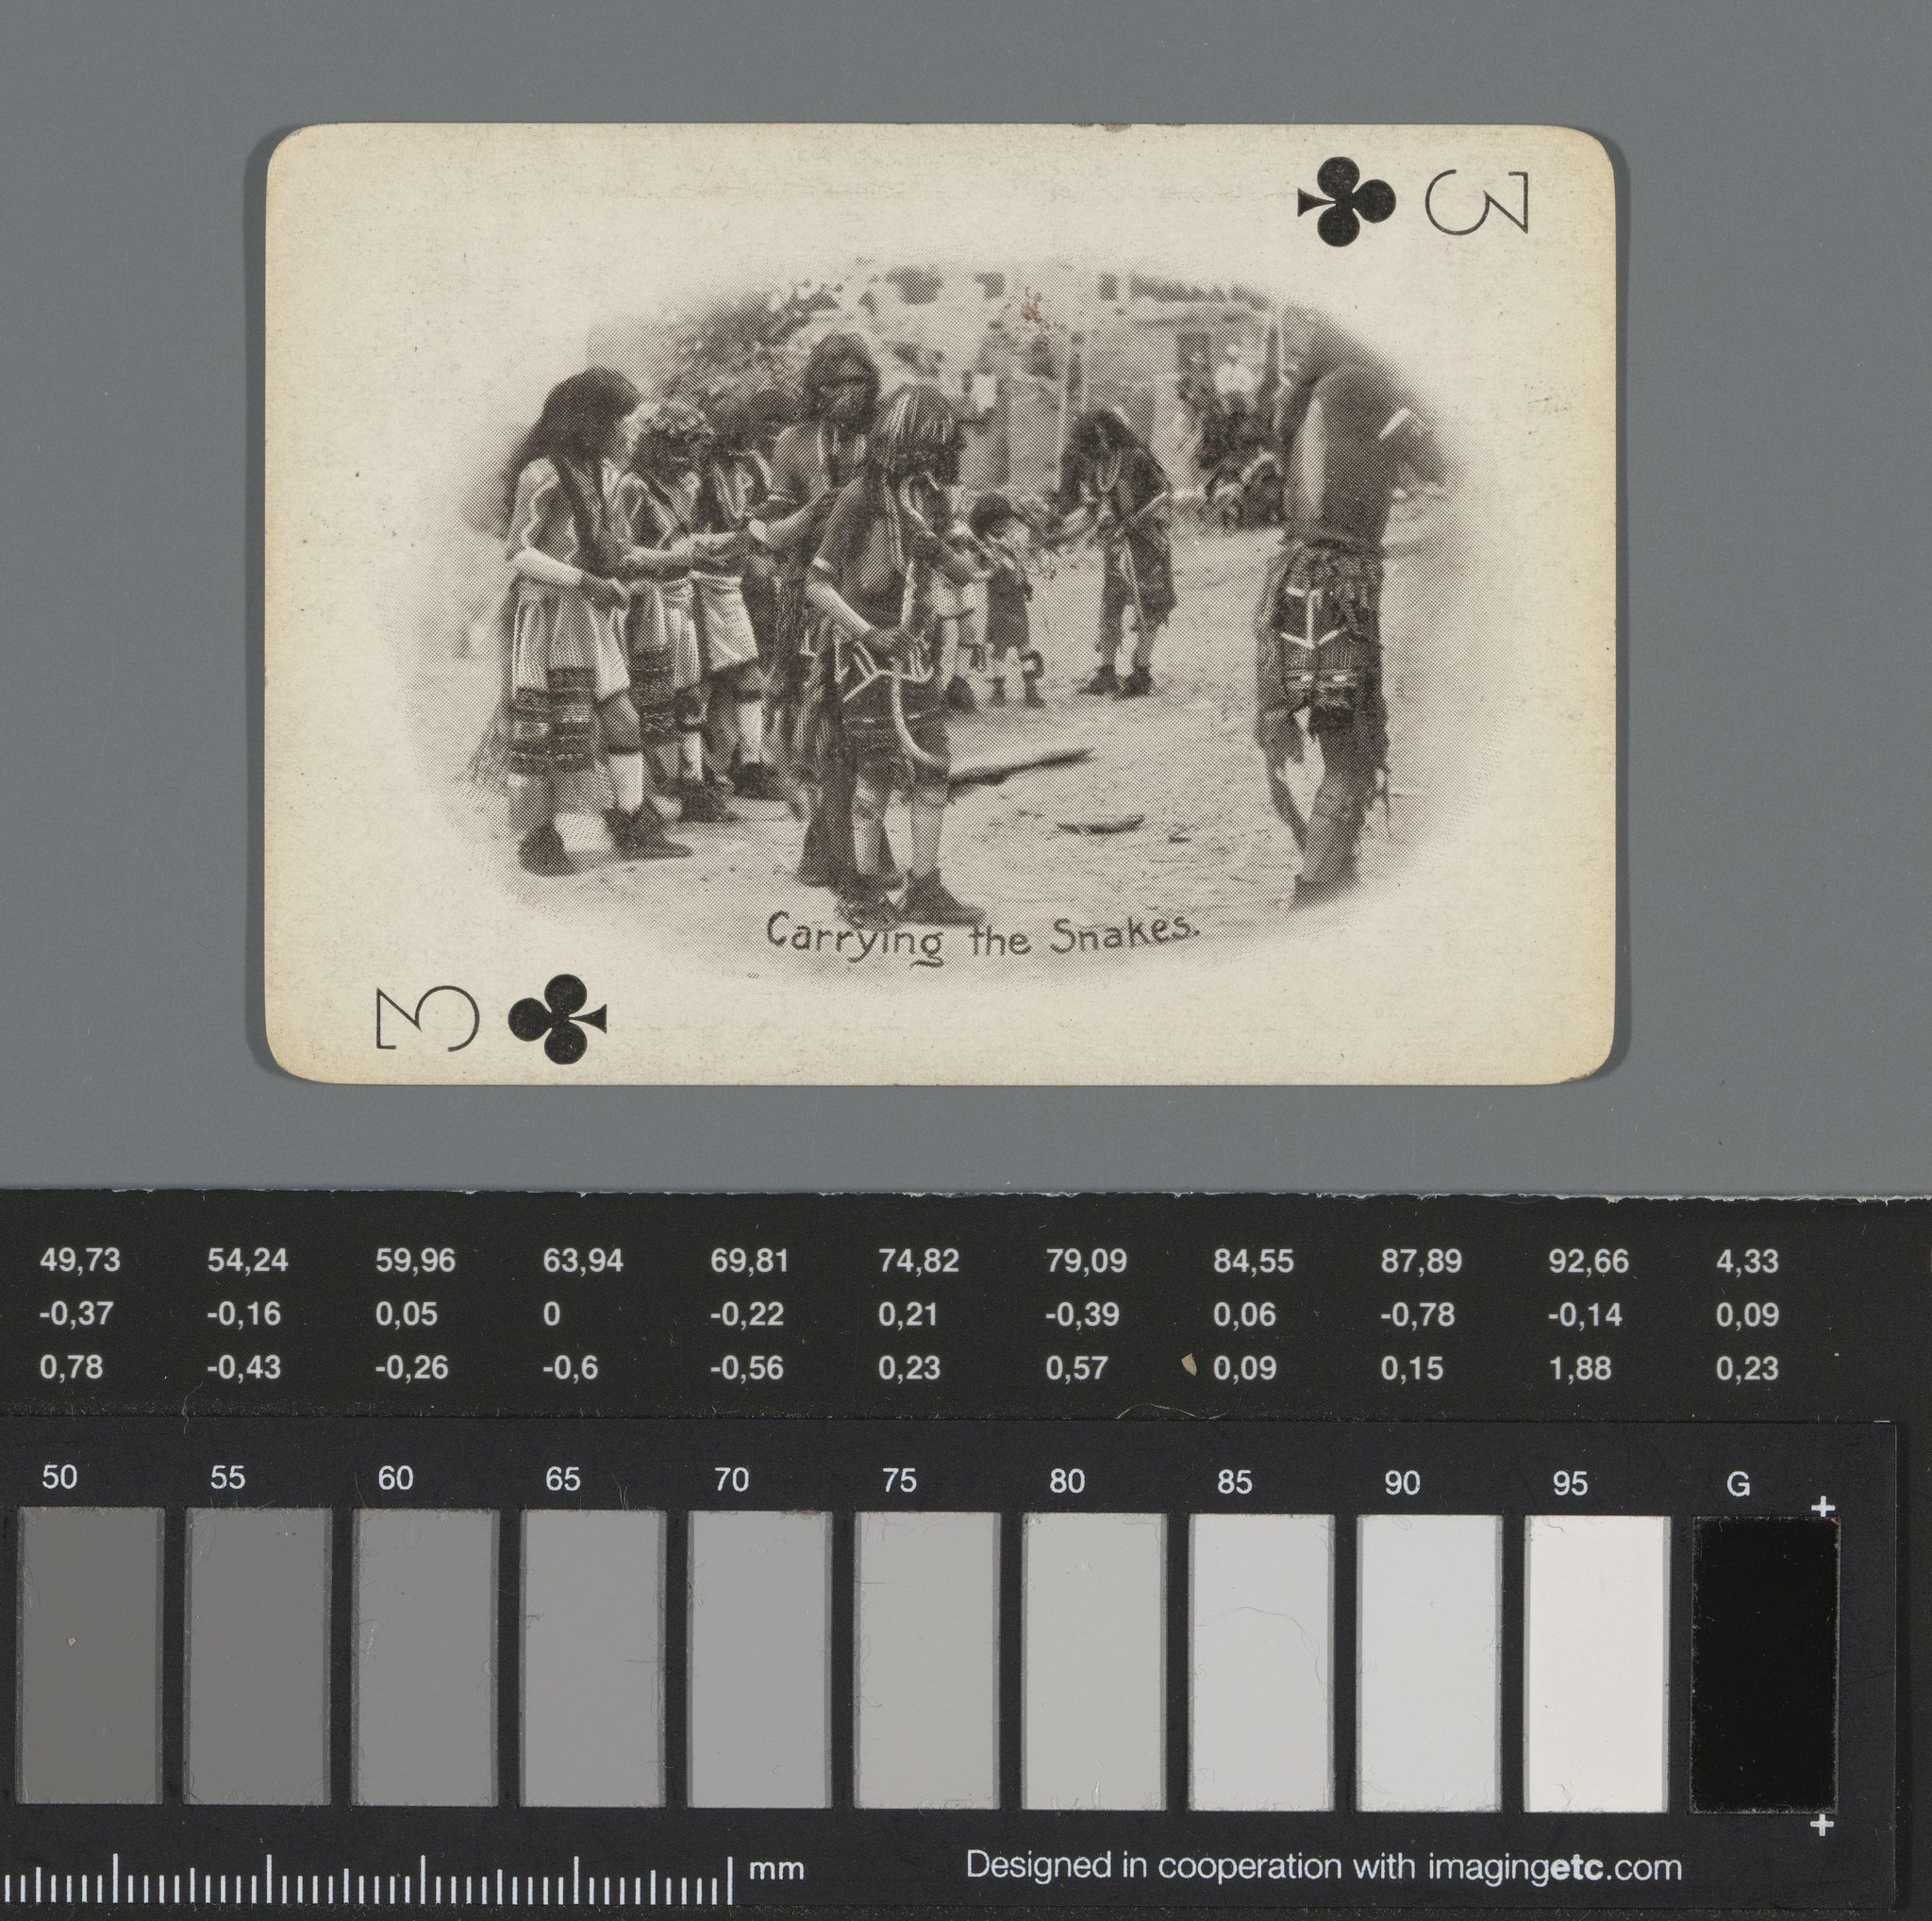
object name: photograph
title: Klaver drie met ‘snake dance’, Oraibi, Navajo County, Arizona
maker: adam clark vroman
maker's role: fotograaf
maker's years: 1856-1916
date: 1900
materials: paper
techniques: autotype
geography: los angeles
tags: arizona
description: Speelkaart uit doosje met 53 speelkaarten met afbeeldingen in autotypie van Native Americans. De inhoud bevat een complete set speelkaarten inclusief joker.